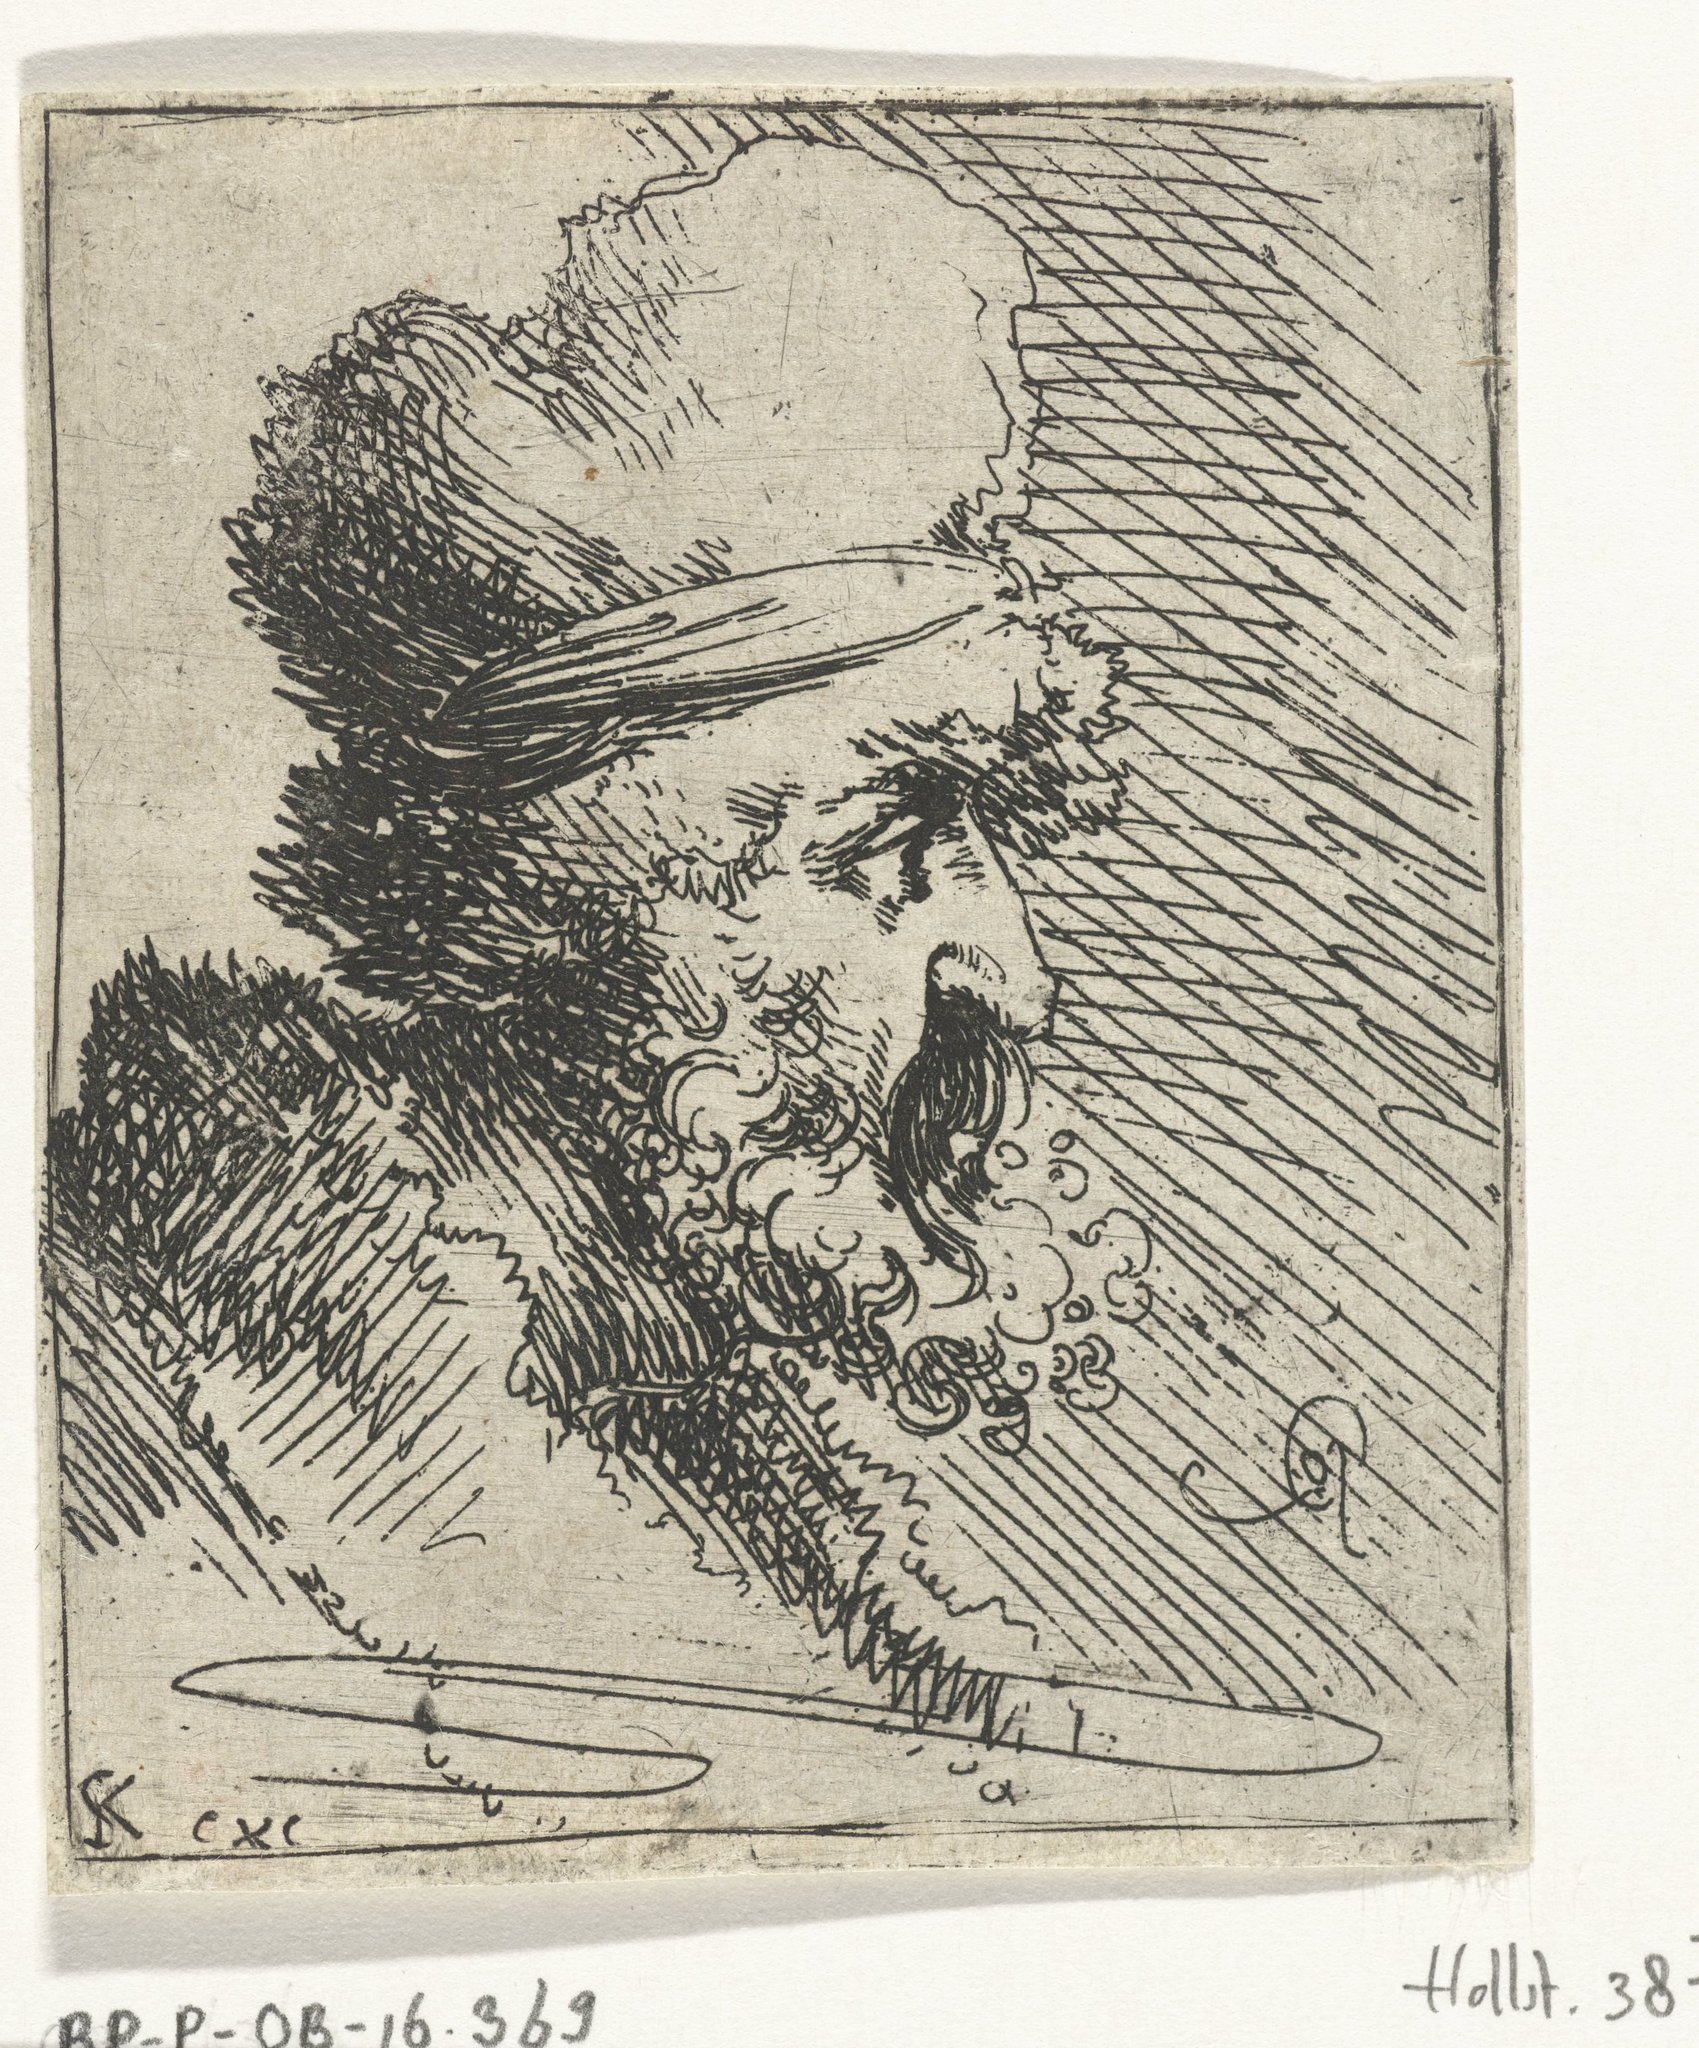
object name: print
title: Kop van een man met baard en muts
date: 1615-1647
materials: paper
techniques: etching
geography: netherlands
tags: head-gear: cap (+ men's clothes), old man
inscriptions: collector's mark: Lugt 240